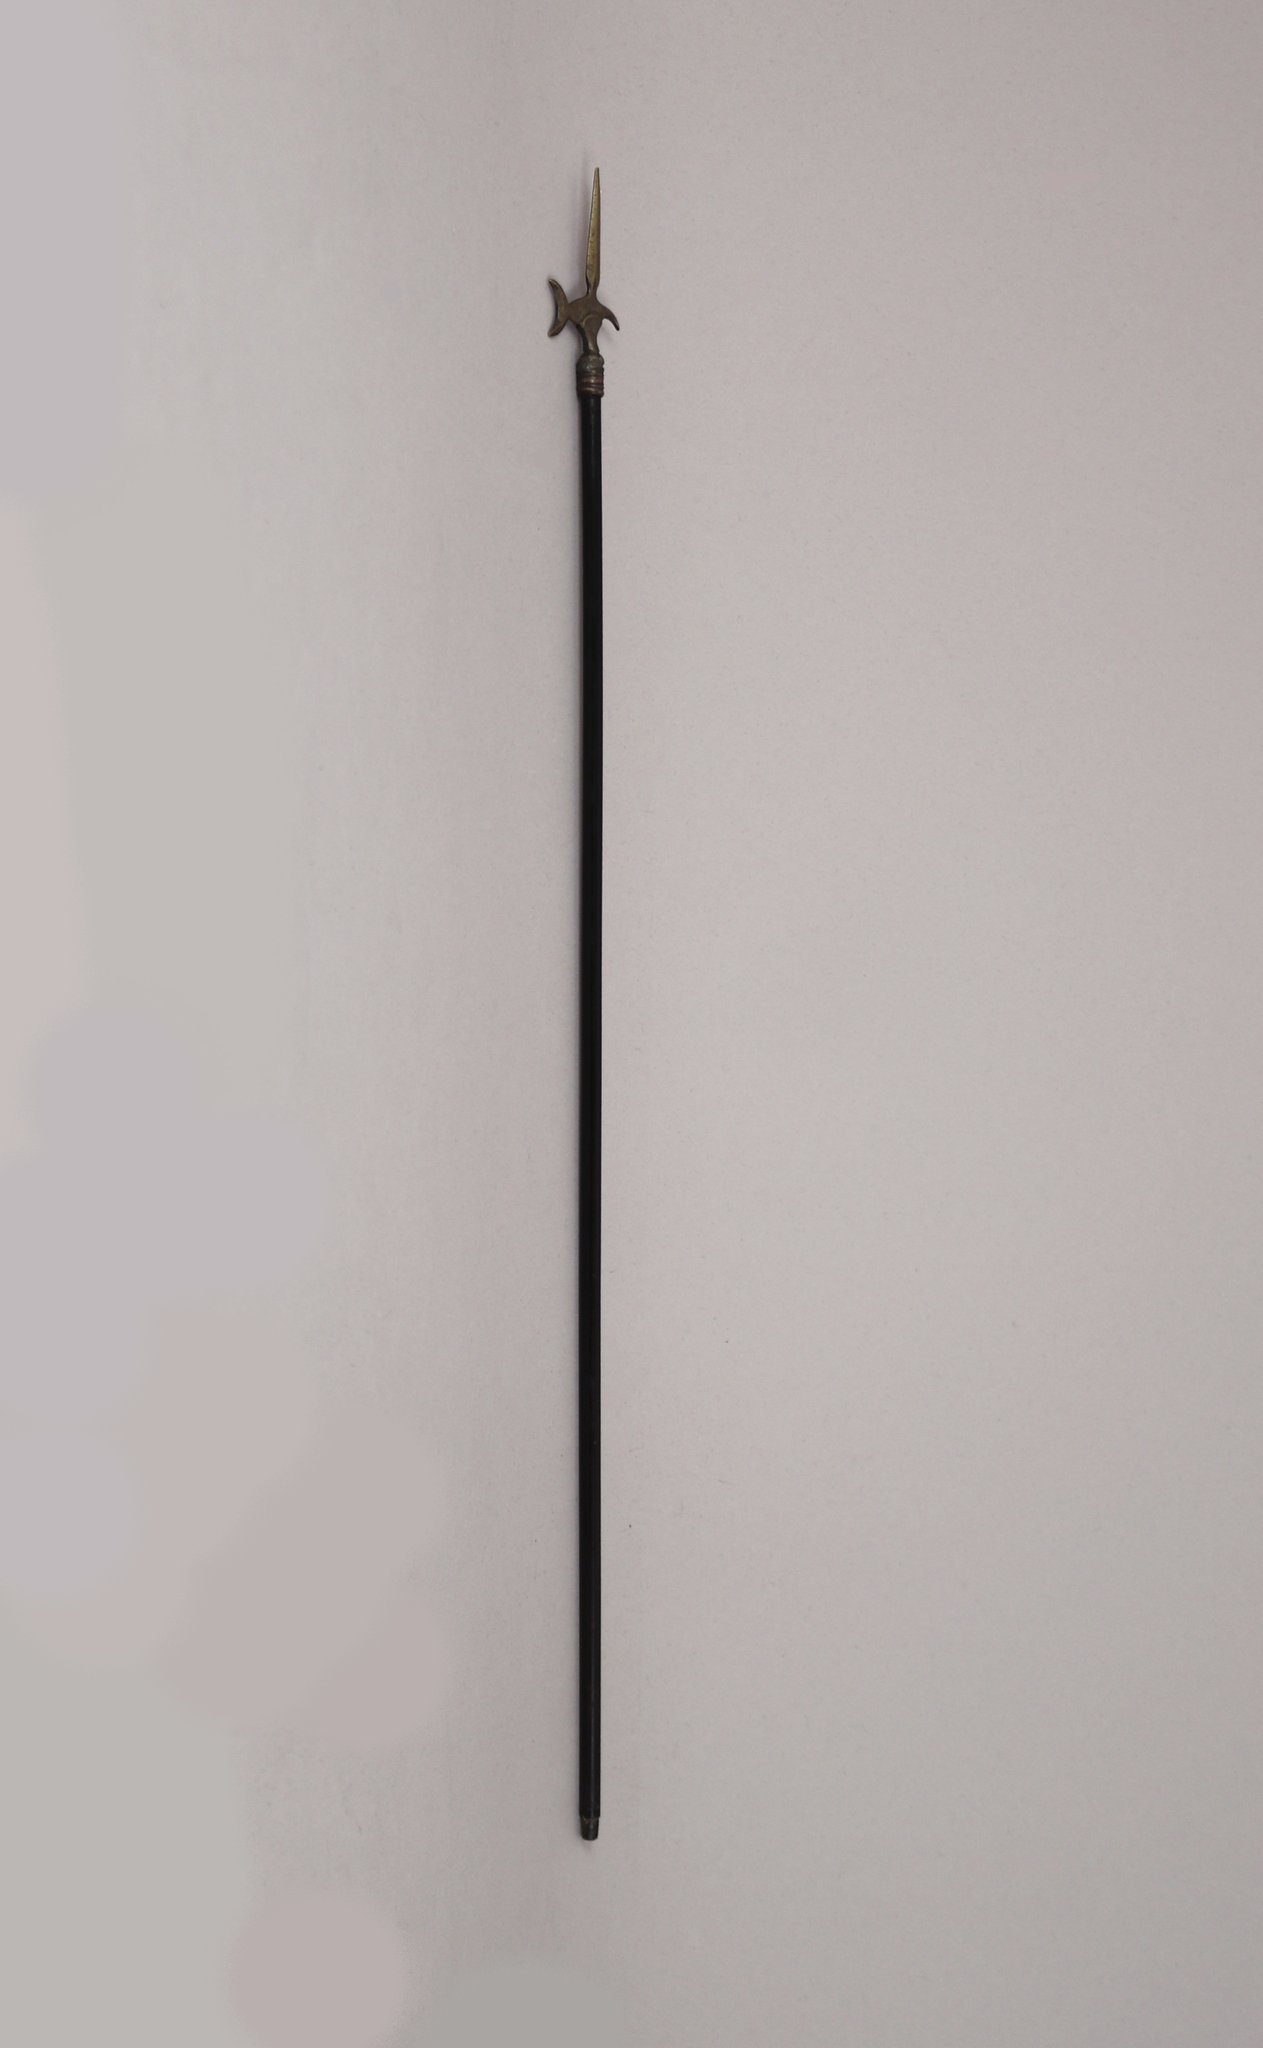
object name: crèche accessory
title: Halberd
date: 1701-1800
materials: steel, wood